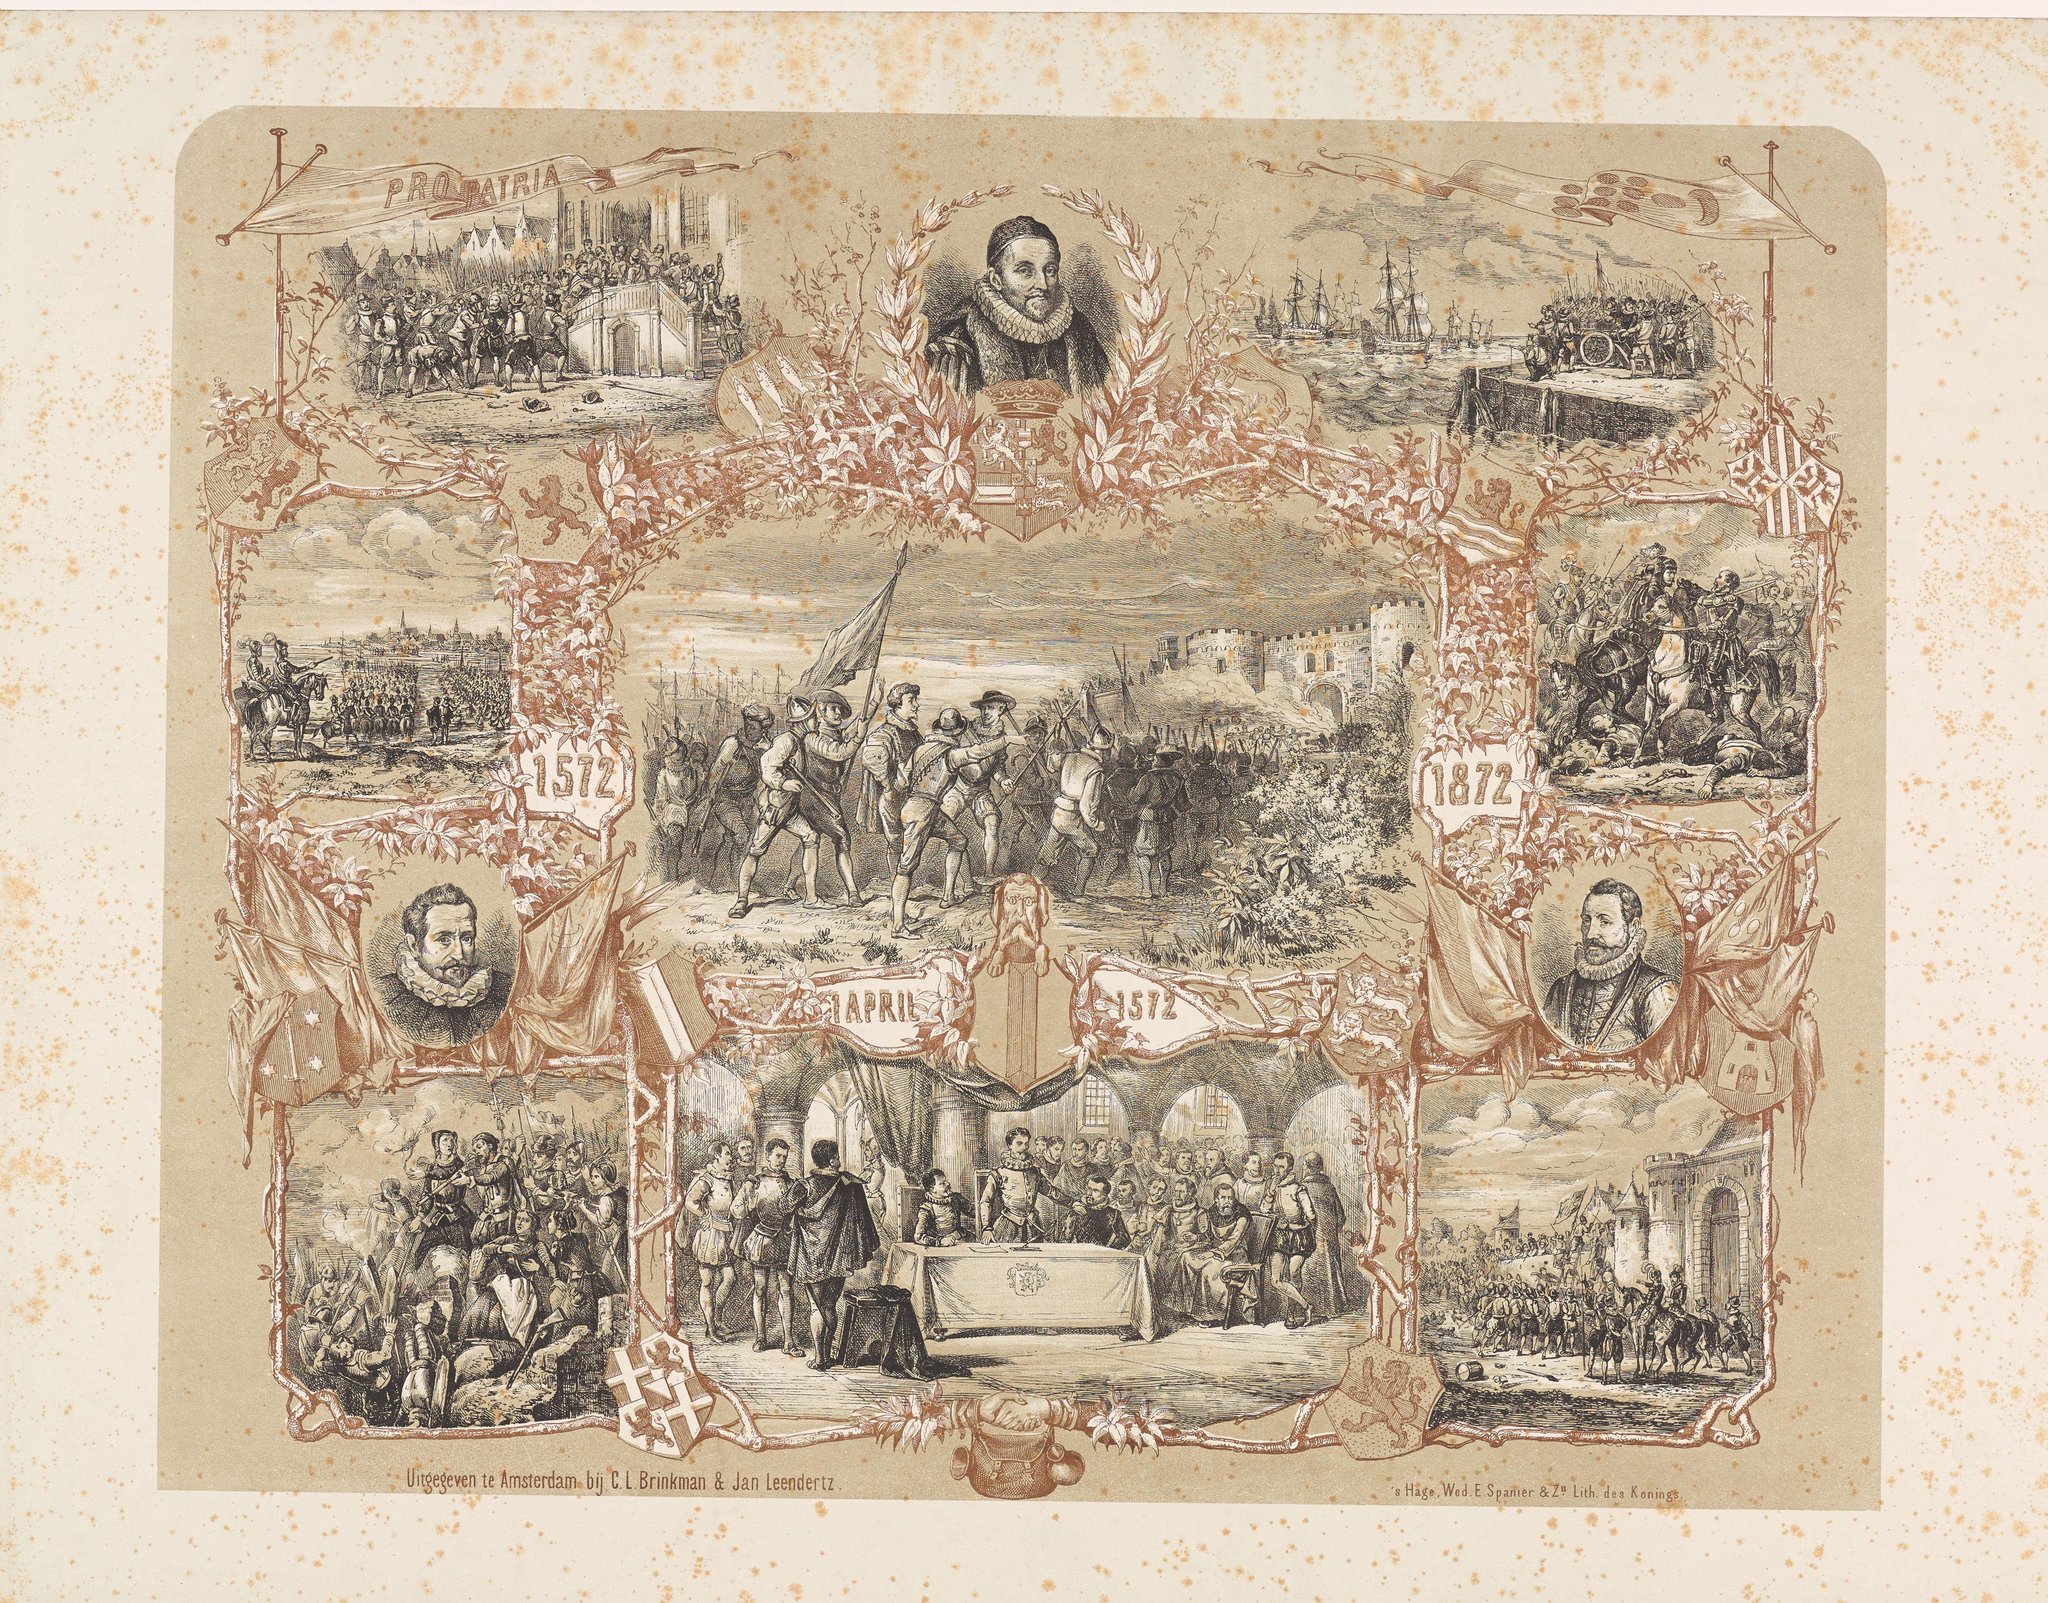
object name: print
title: Nationale feestviering op 1 april 1872 van de 300-jarige inname van Den Briel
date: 1872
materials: paper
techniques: tone lithography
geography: the hague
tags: brielle, delft, william i (prince of orange), brussels, leiden, politician, filips van marnix van sint-aldegonde, capture of city (after the siege)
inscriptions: collector's mark: Lugt 2228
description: Gedenkblad bij de nationale feestviering op 1 april 1872 van de 300-jarige inname van Den Briel door de watergeuzen op 1 april 1572. Blad met centraal de inname van Den Briel, hieromheen zeven voorstellingen van historische gebeurtenissen uit het begin van de Nederlandse Opstand en drie portretten, bovenaan Willem van Oranje. Tussen de scènes ranken, wapens en vaandels.